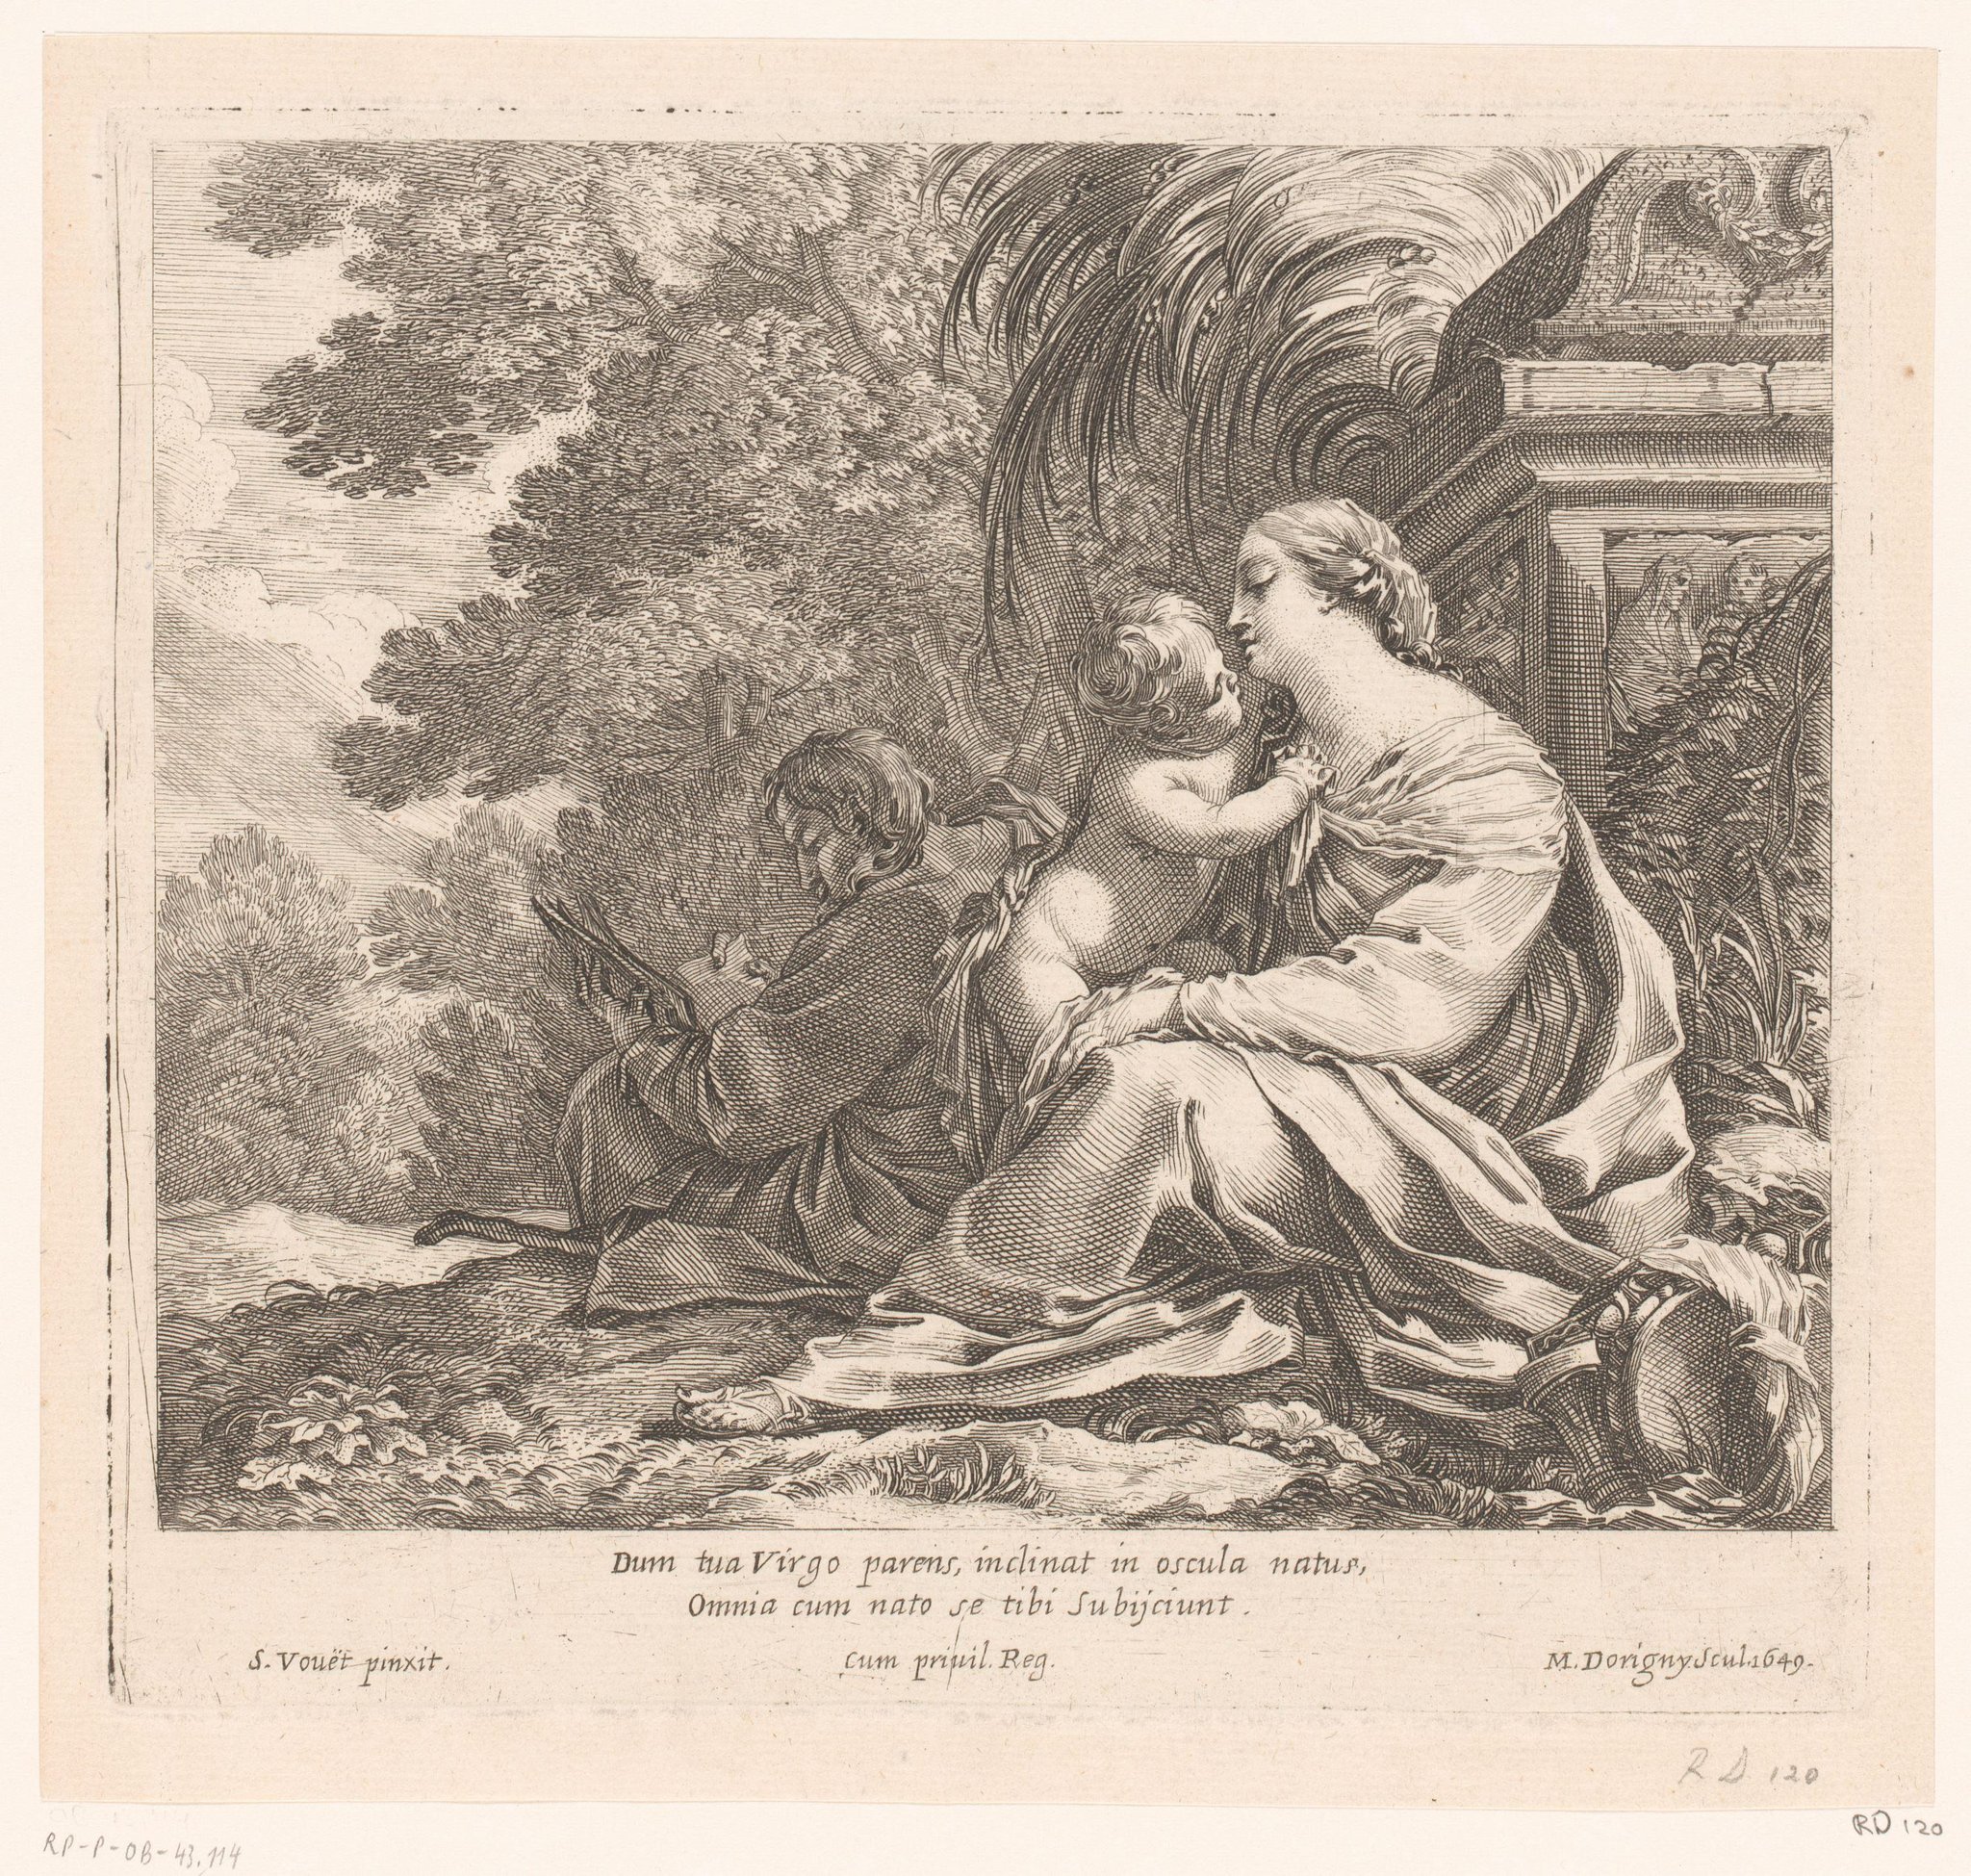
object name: print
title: Rust op de vlucht naar Egypte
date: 1649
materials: paper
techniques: engraving, etching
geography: france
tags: rest on the flight into egypt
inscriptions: collector's mark: Lugt 2228